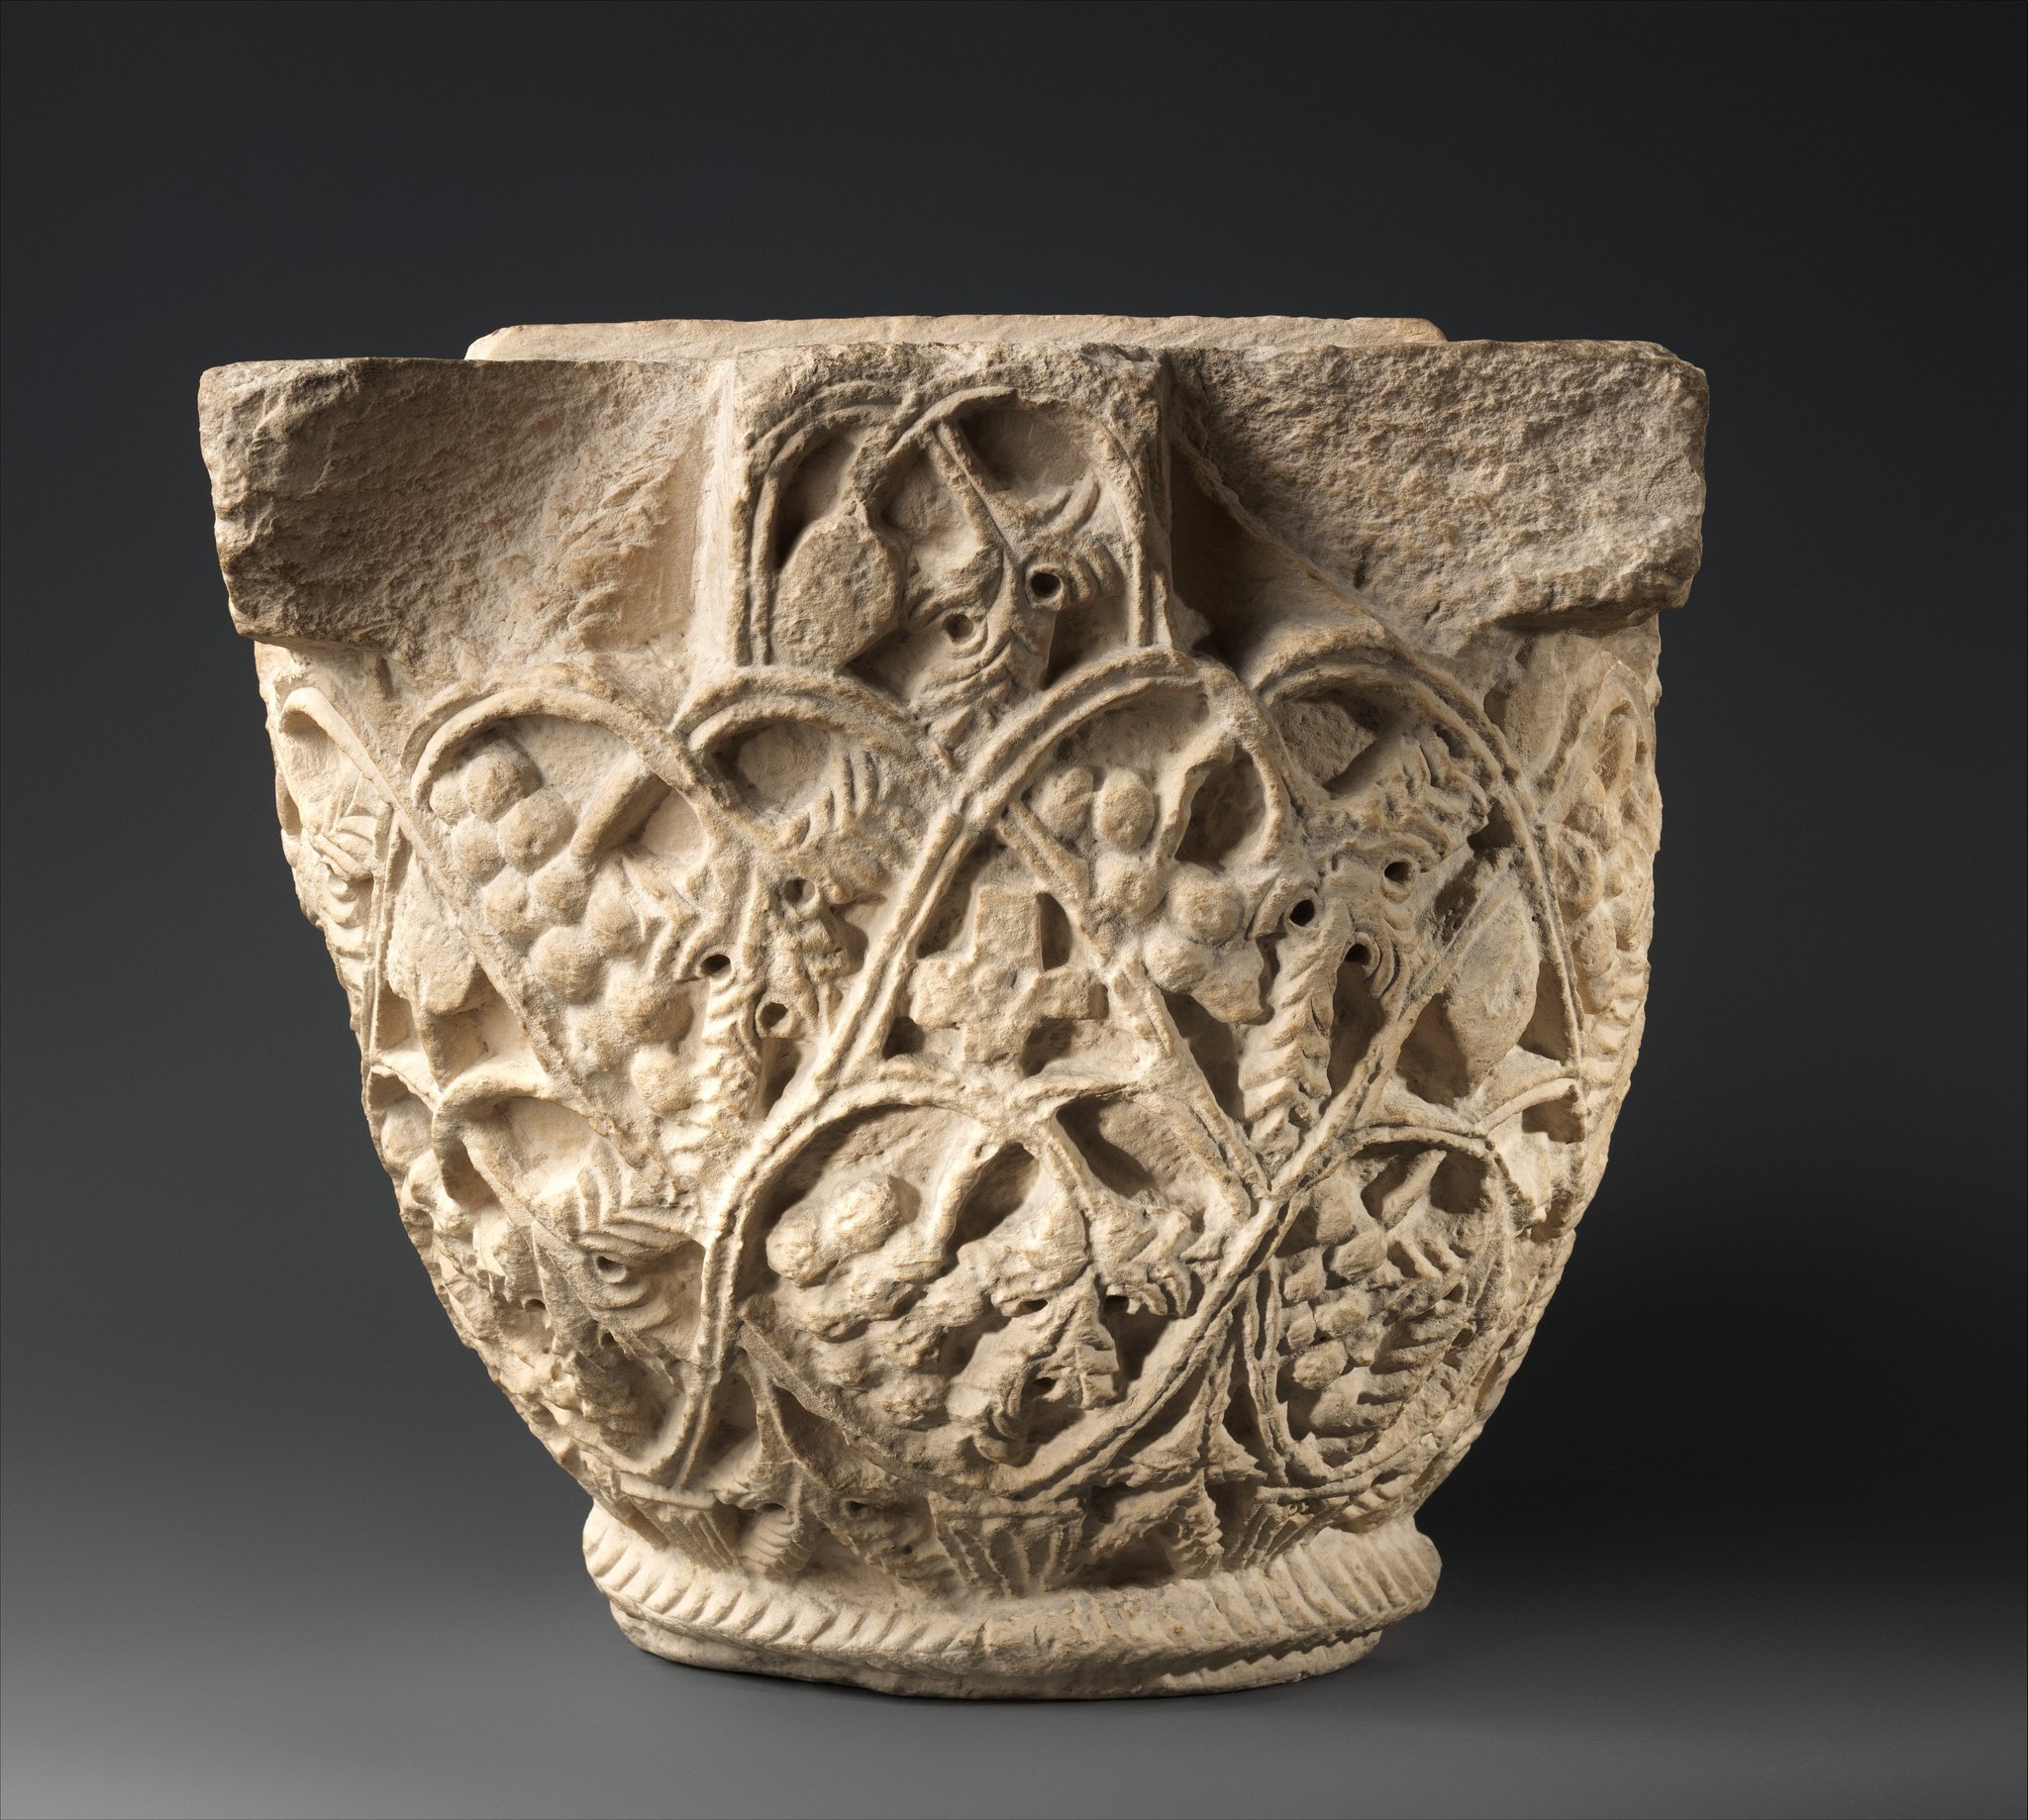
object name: capital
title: Capital with a Pattern of Vines with Grapes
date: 501-700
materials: limestone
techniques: carving, relief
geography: egypt